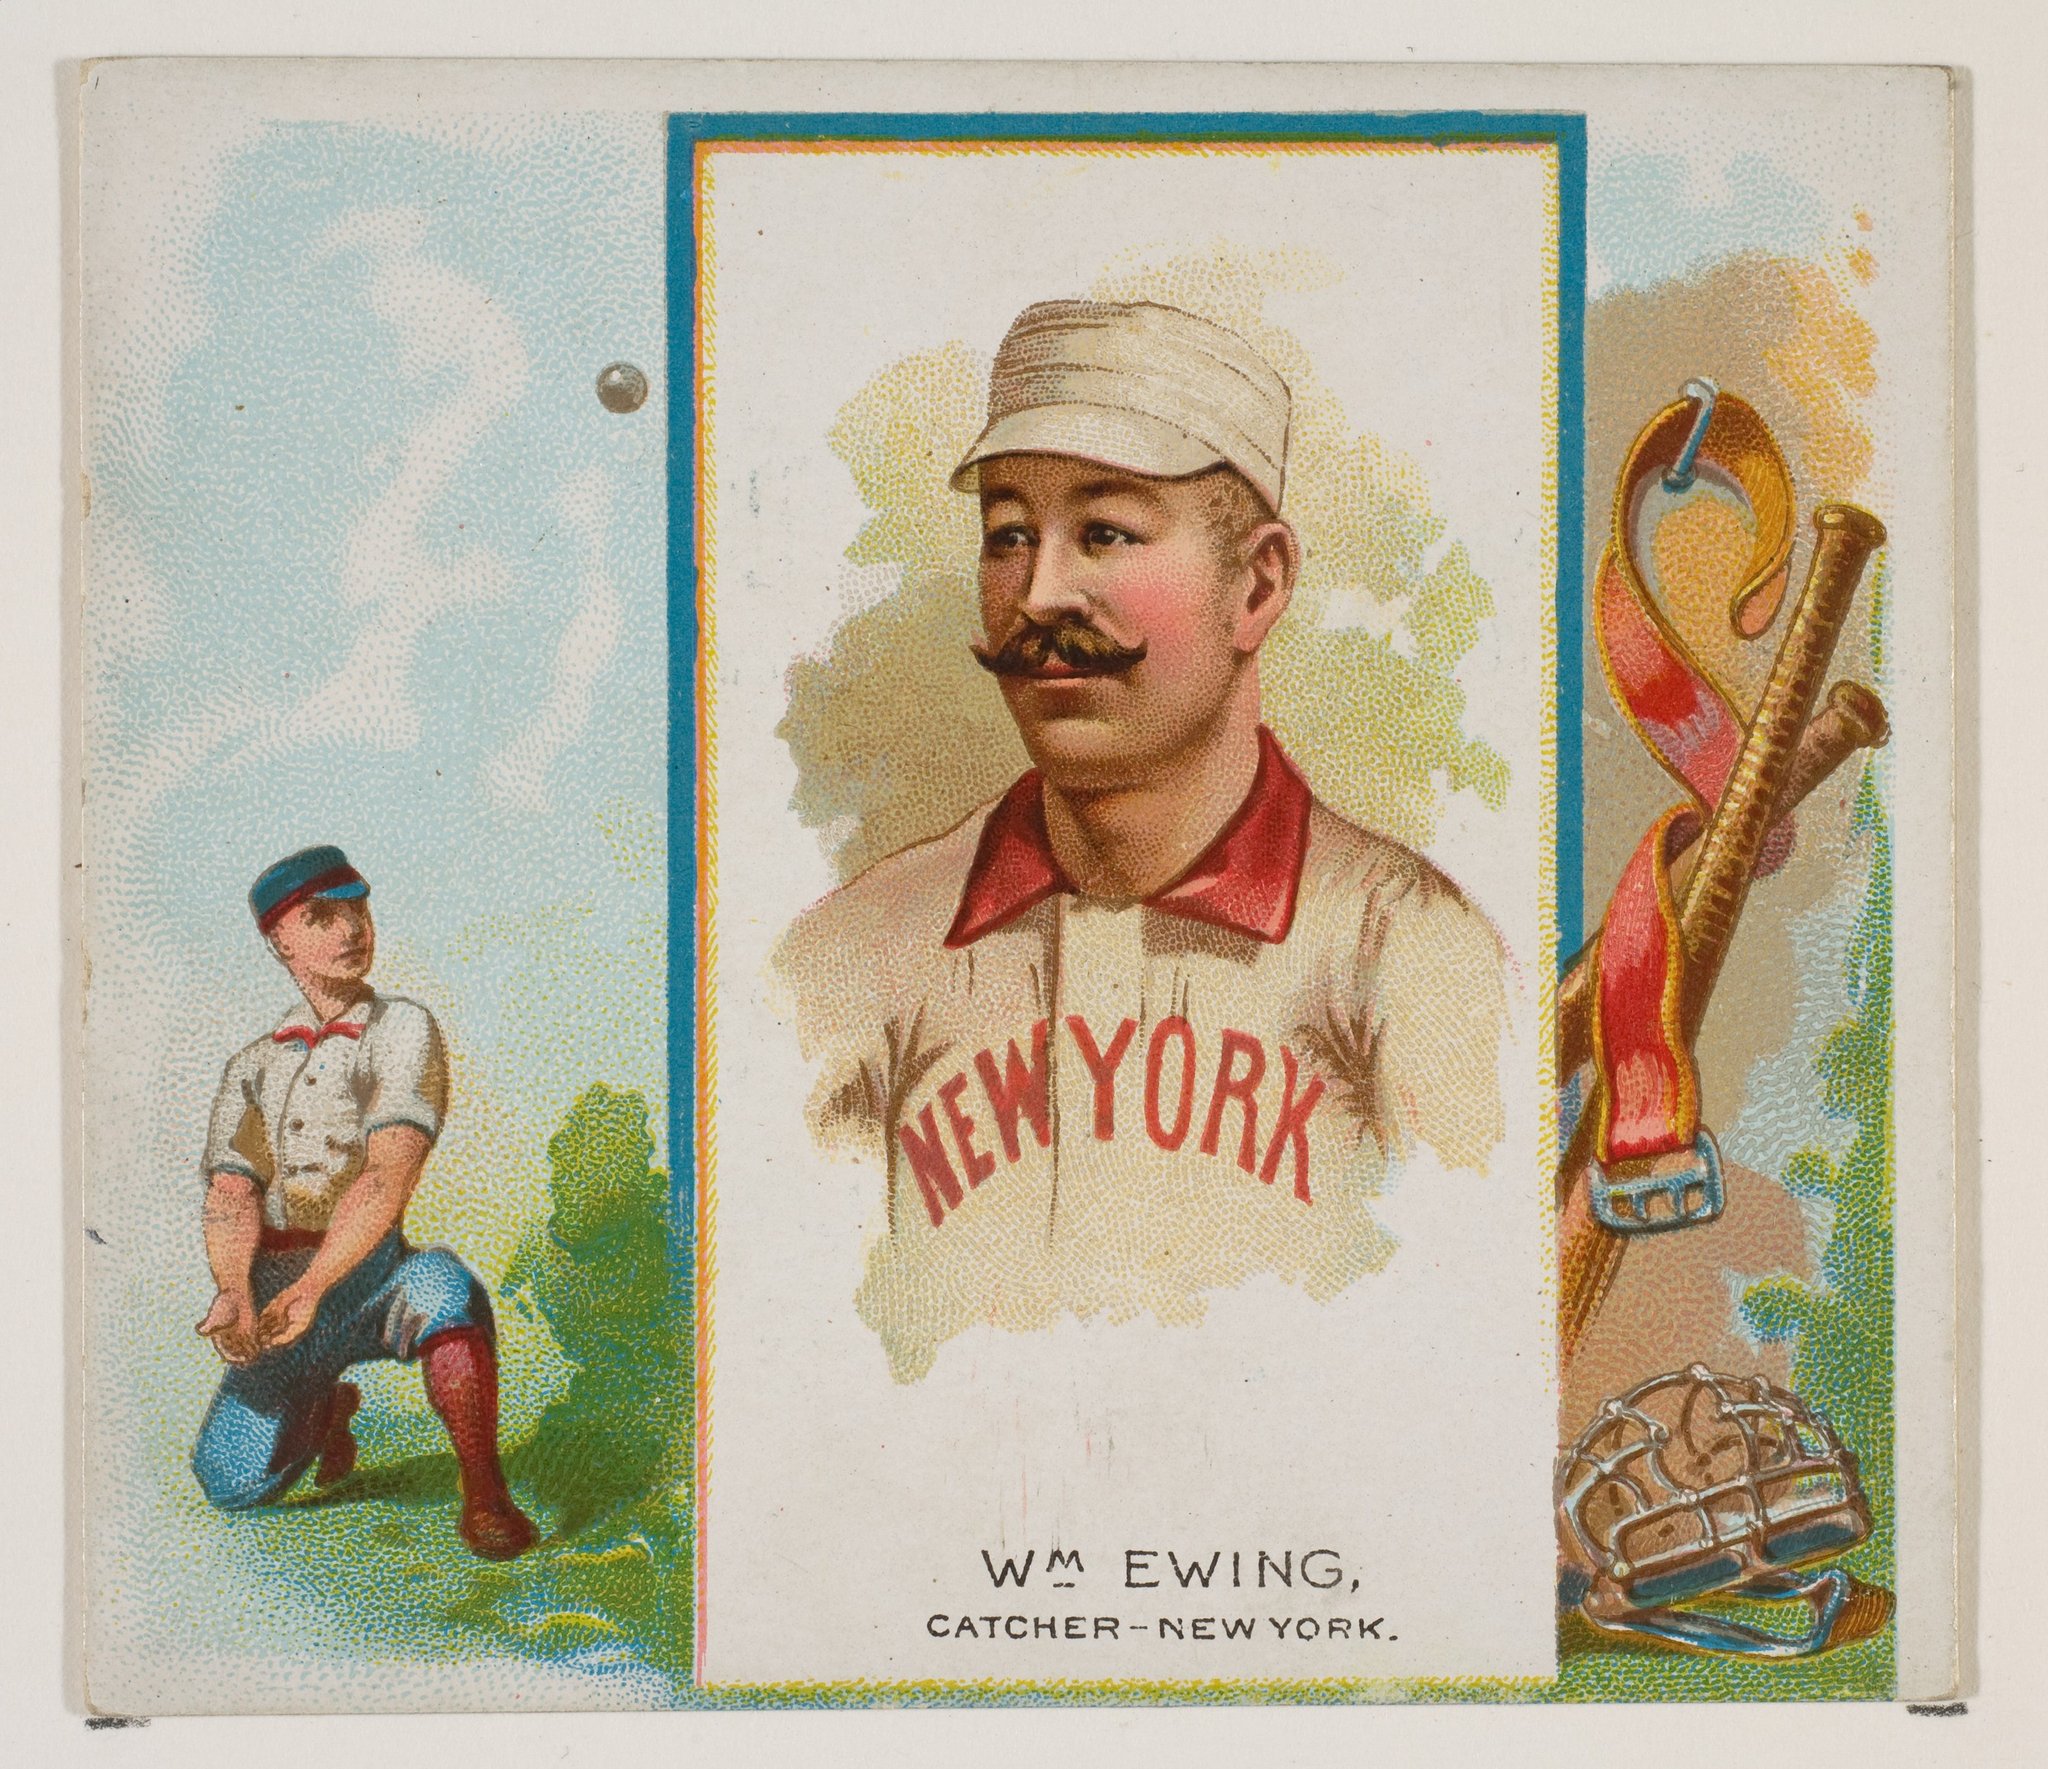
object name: baseball card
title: William Ewing, Catcher, New York, from World's Champions, Second Series (N43) for Allen & Ginter Cigarettes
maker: allen & ginter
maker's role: publisher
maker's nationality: american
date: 1888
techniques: lithography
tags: men,portraits,baseball,athletes